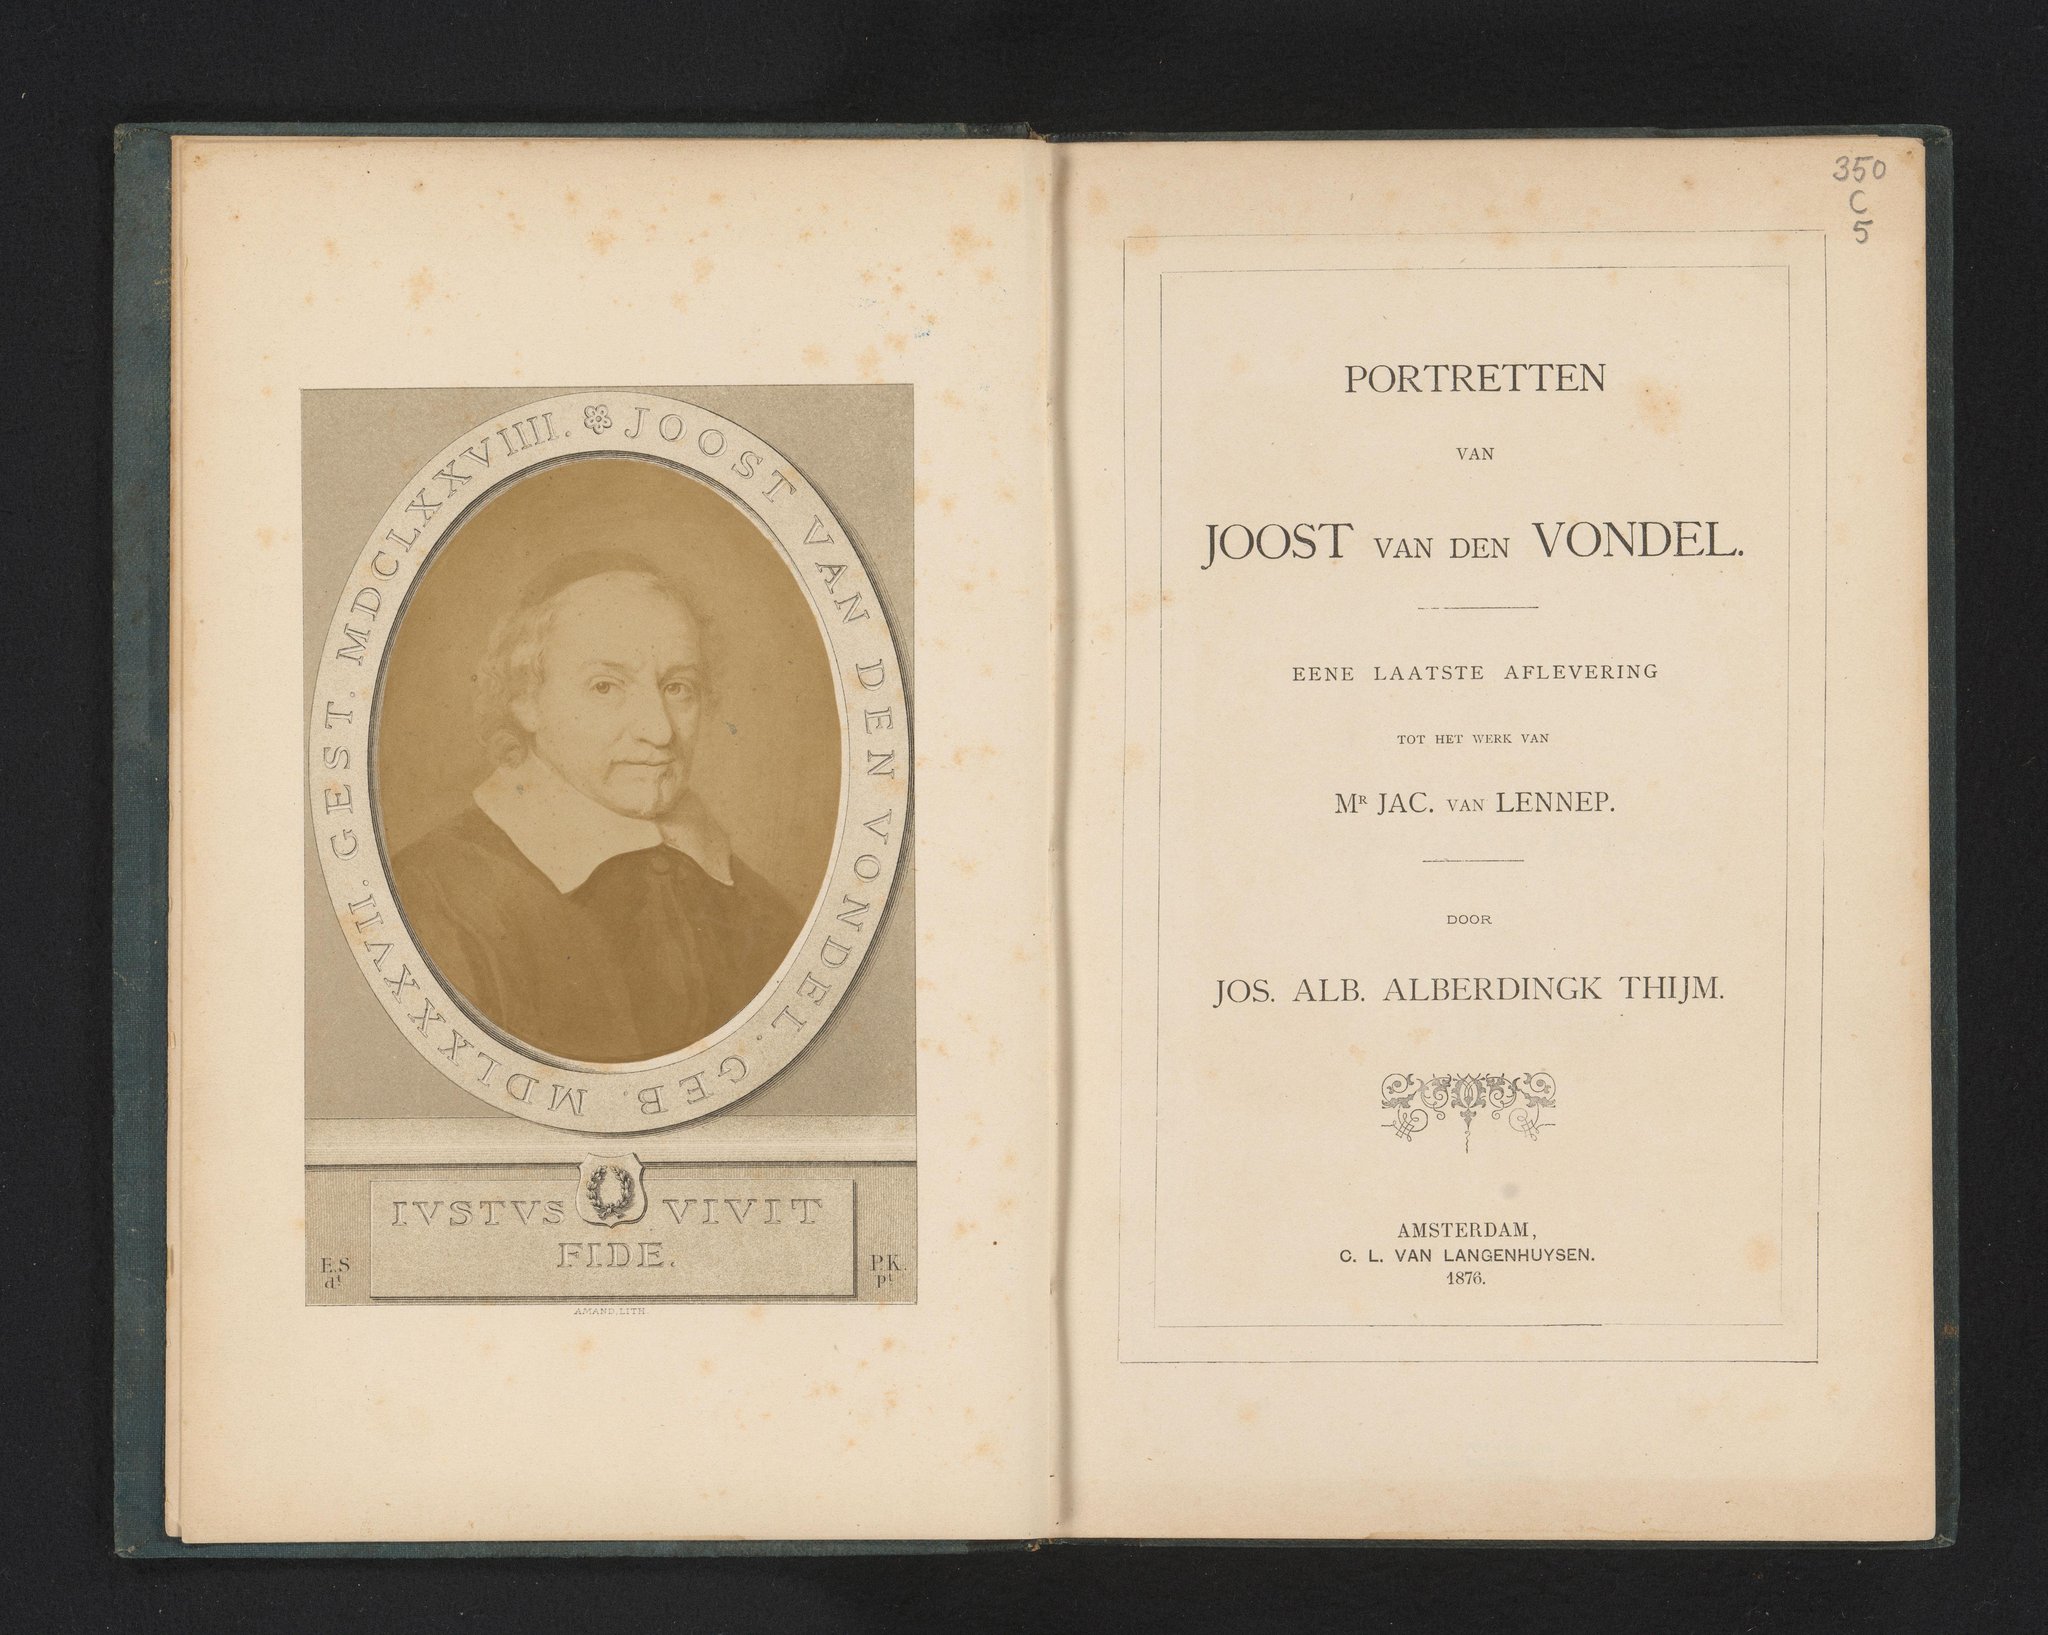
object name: book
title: Portretten van Joost van den Vondel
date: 1876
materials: cardboard, linen, paper, photographic support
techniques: albumen print, lithograph, printing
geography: amsterdam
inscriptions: name: ‘HJ Tuckley’